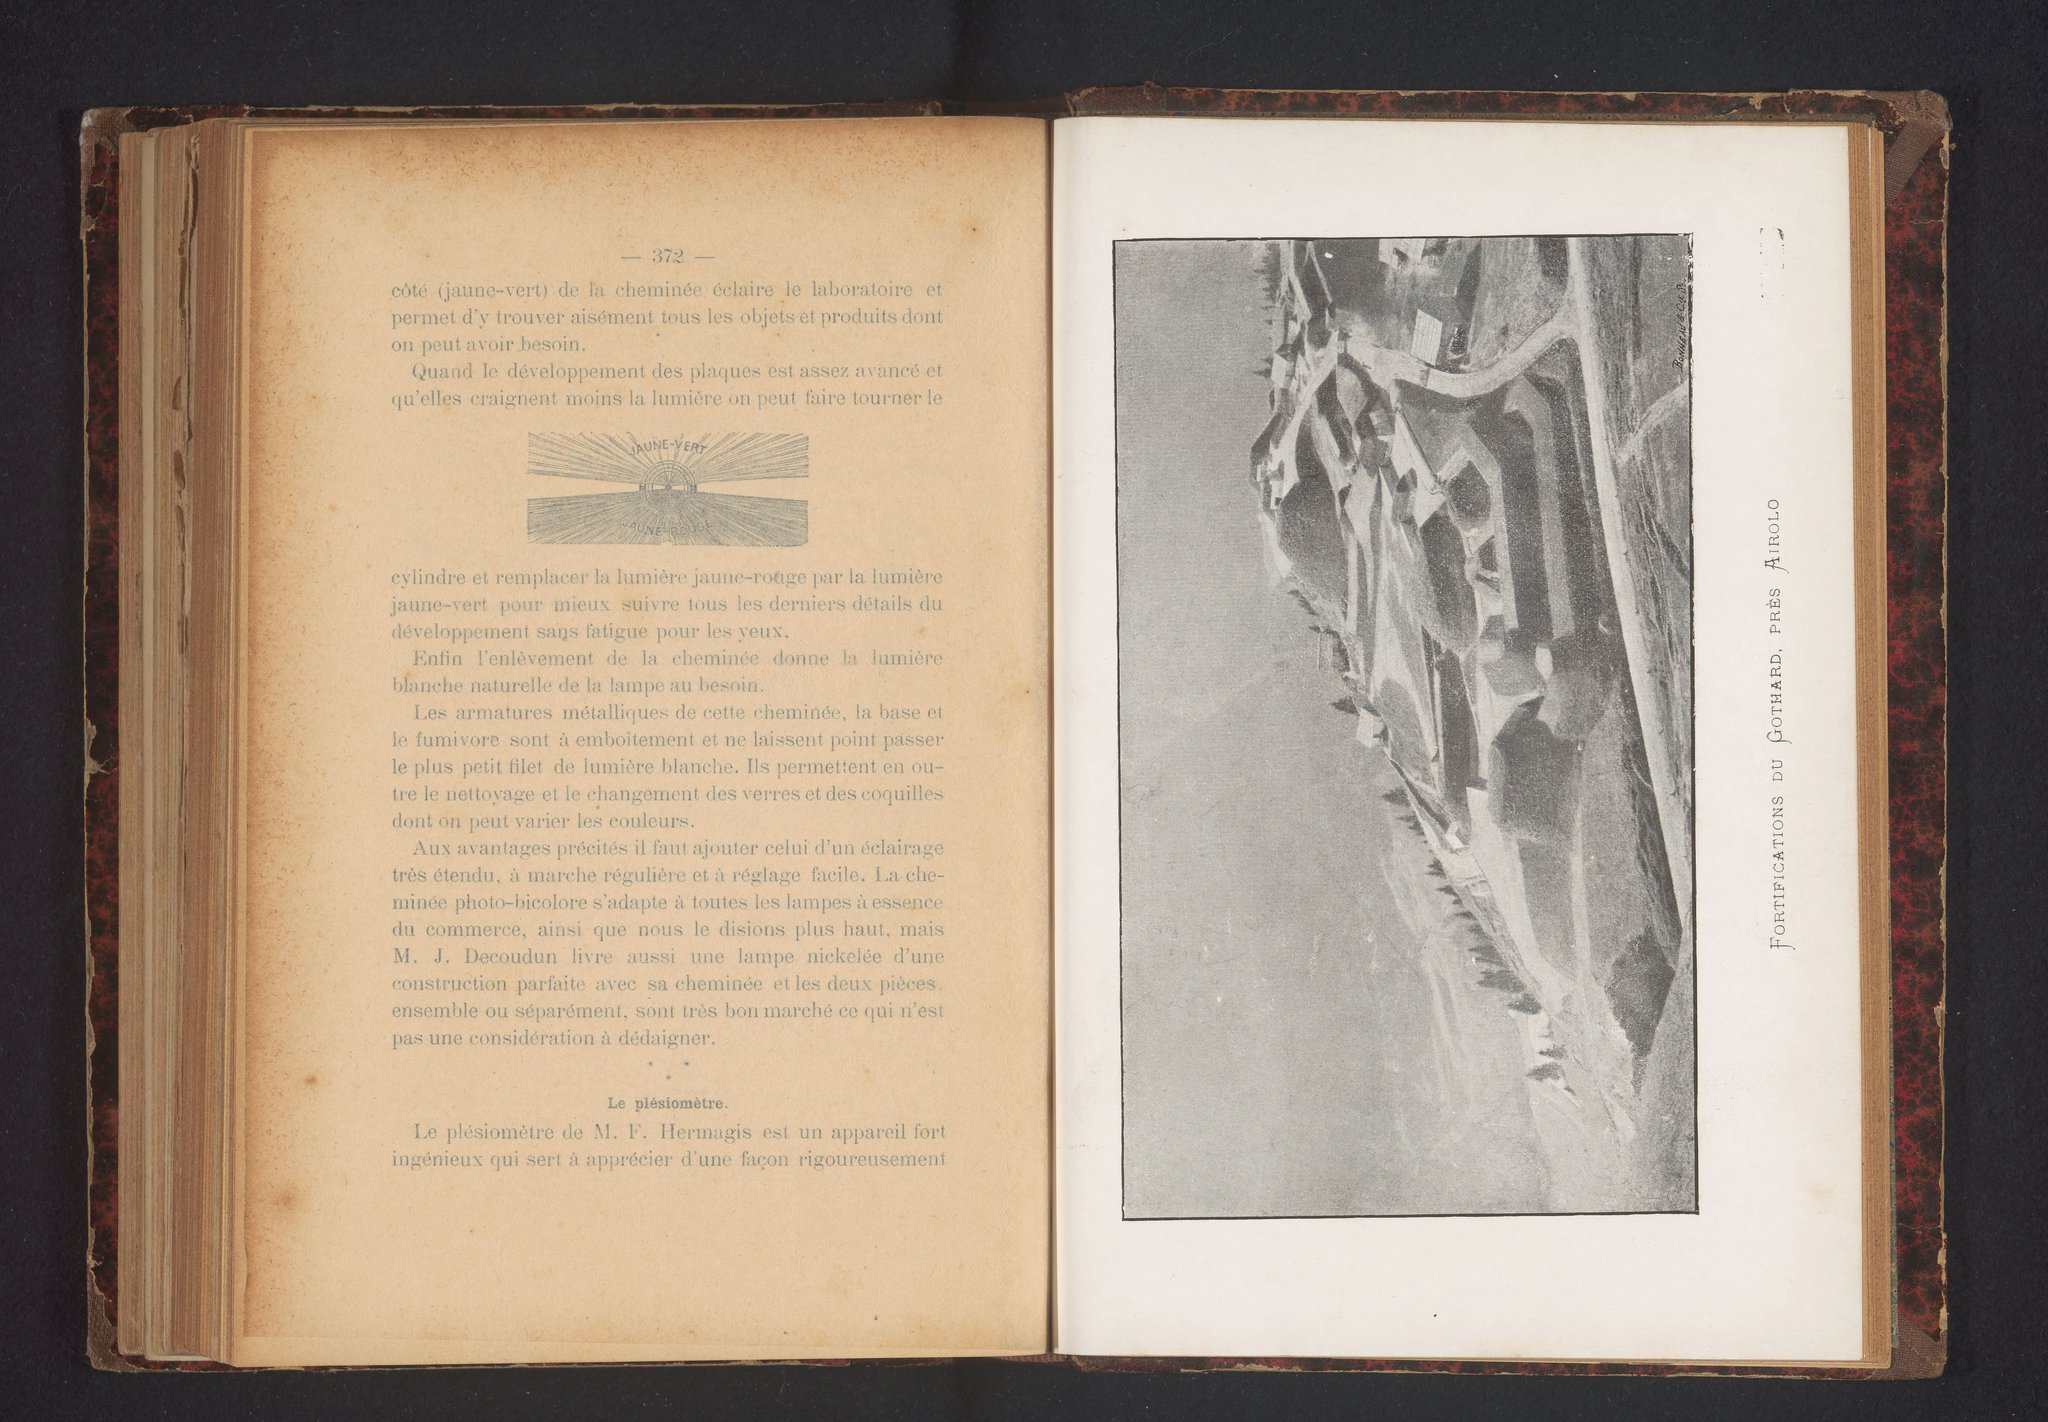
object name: photomechanical print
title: Gezicht op vestingwerken aan de Gotthardpass in de buurt van Airolo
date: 1890-1895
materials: paper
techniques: autotype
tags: fortifications, military engineering, mountains